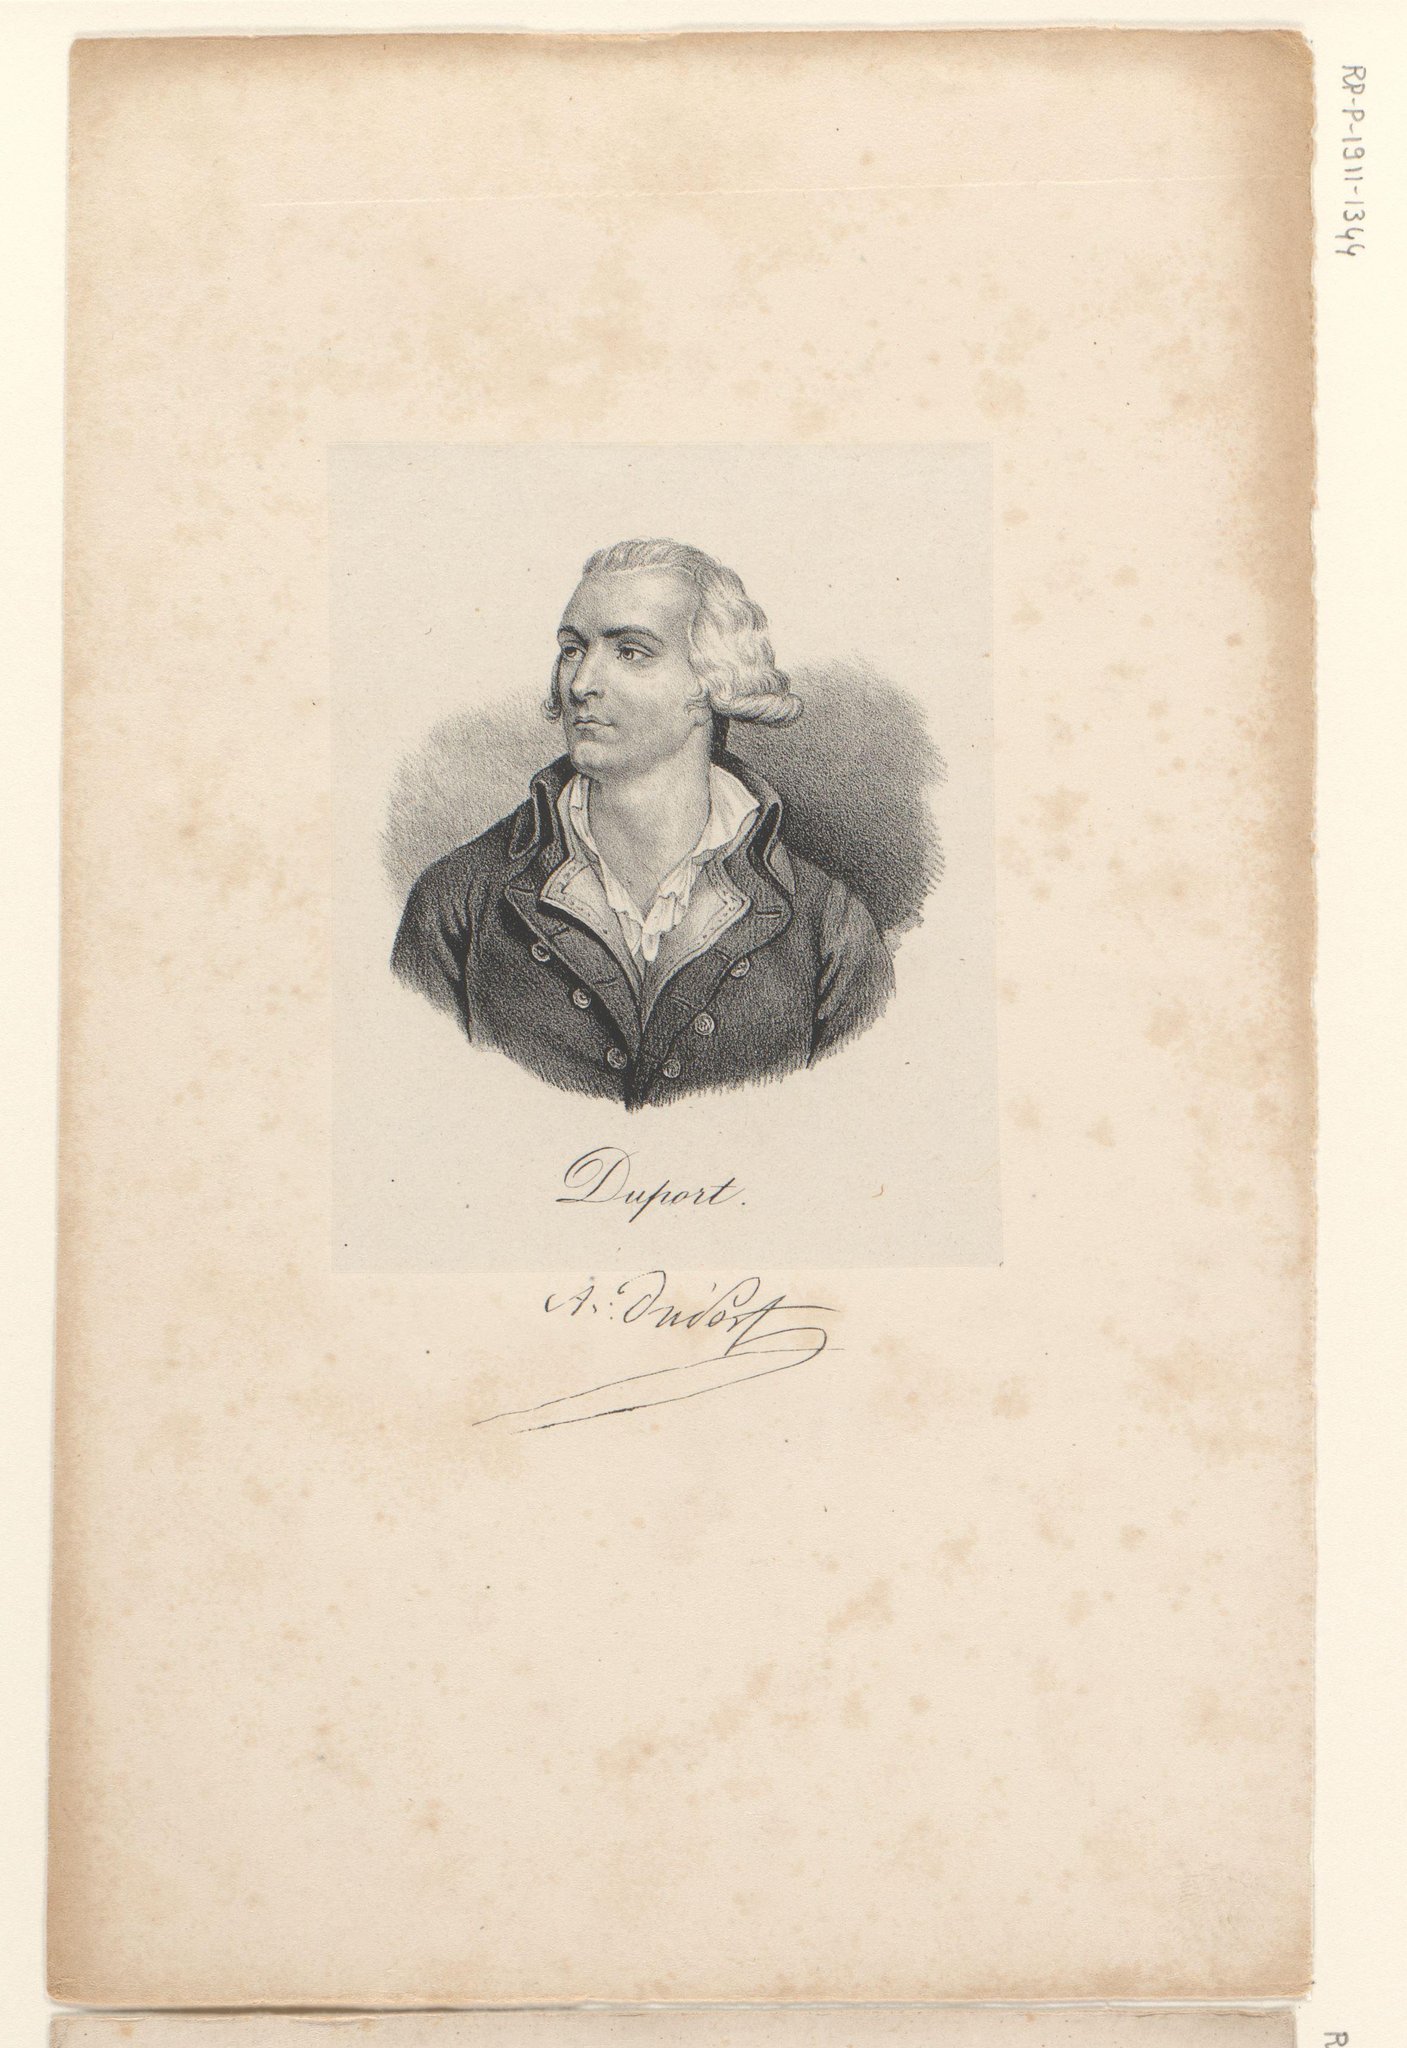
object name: print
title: Duport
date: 1818-1842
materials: paper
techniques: lithograph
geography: paris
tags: politician, historical persons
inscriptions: collector's mark: Lugt 2228a